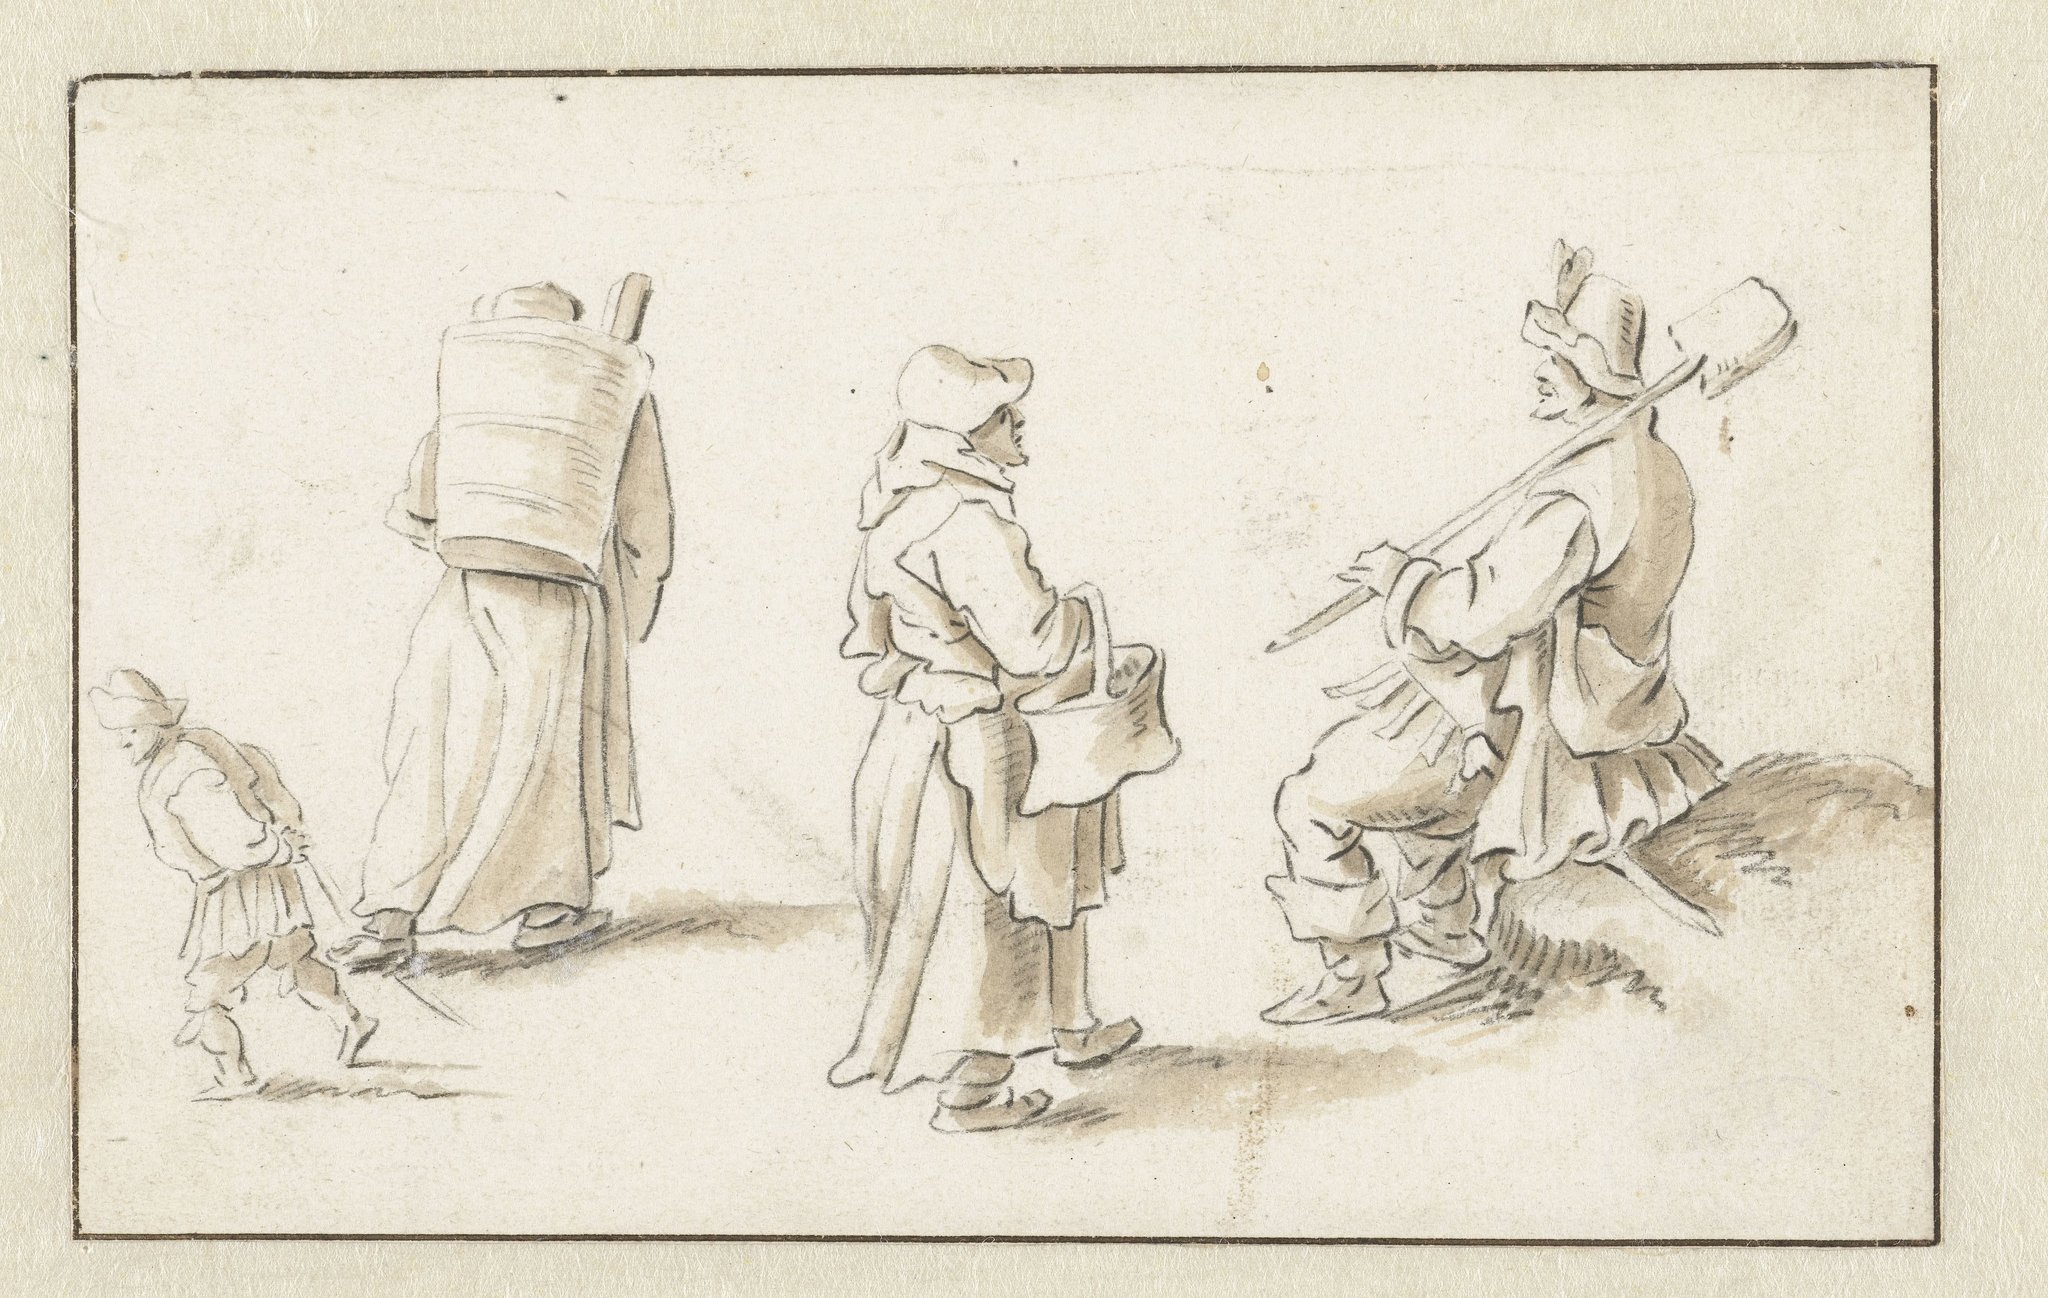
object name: drawing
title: Twee vrouwen en twee mannen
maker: herman saftleven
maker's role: draughtsman, painter, print maker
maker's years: 1609-1685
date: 1619-1685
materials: chalk, paper, pencil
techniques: brush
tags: sitting figure, standing figure - aa - female human figure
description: Twee staande vrouwen, een zittende man en een man lopend naar links.